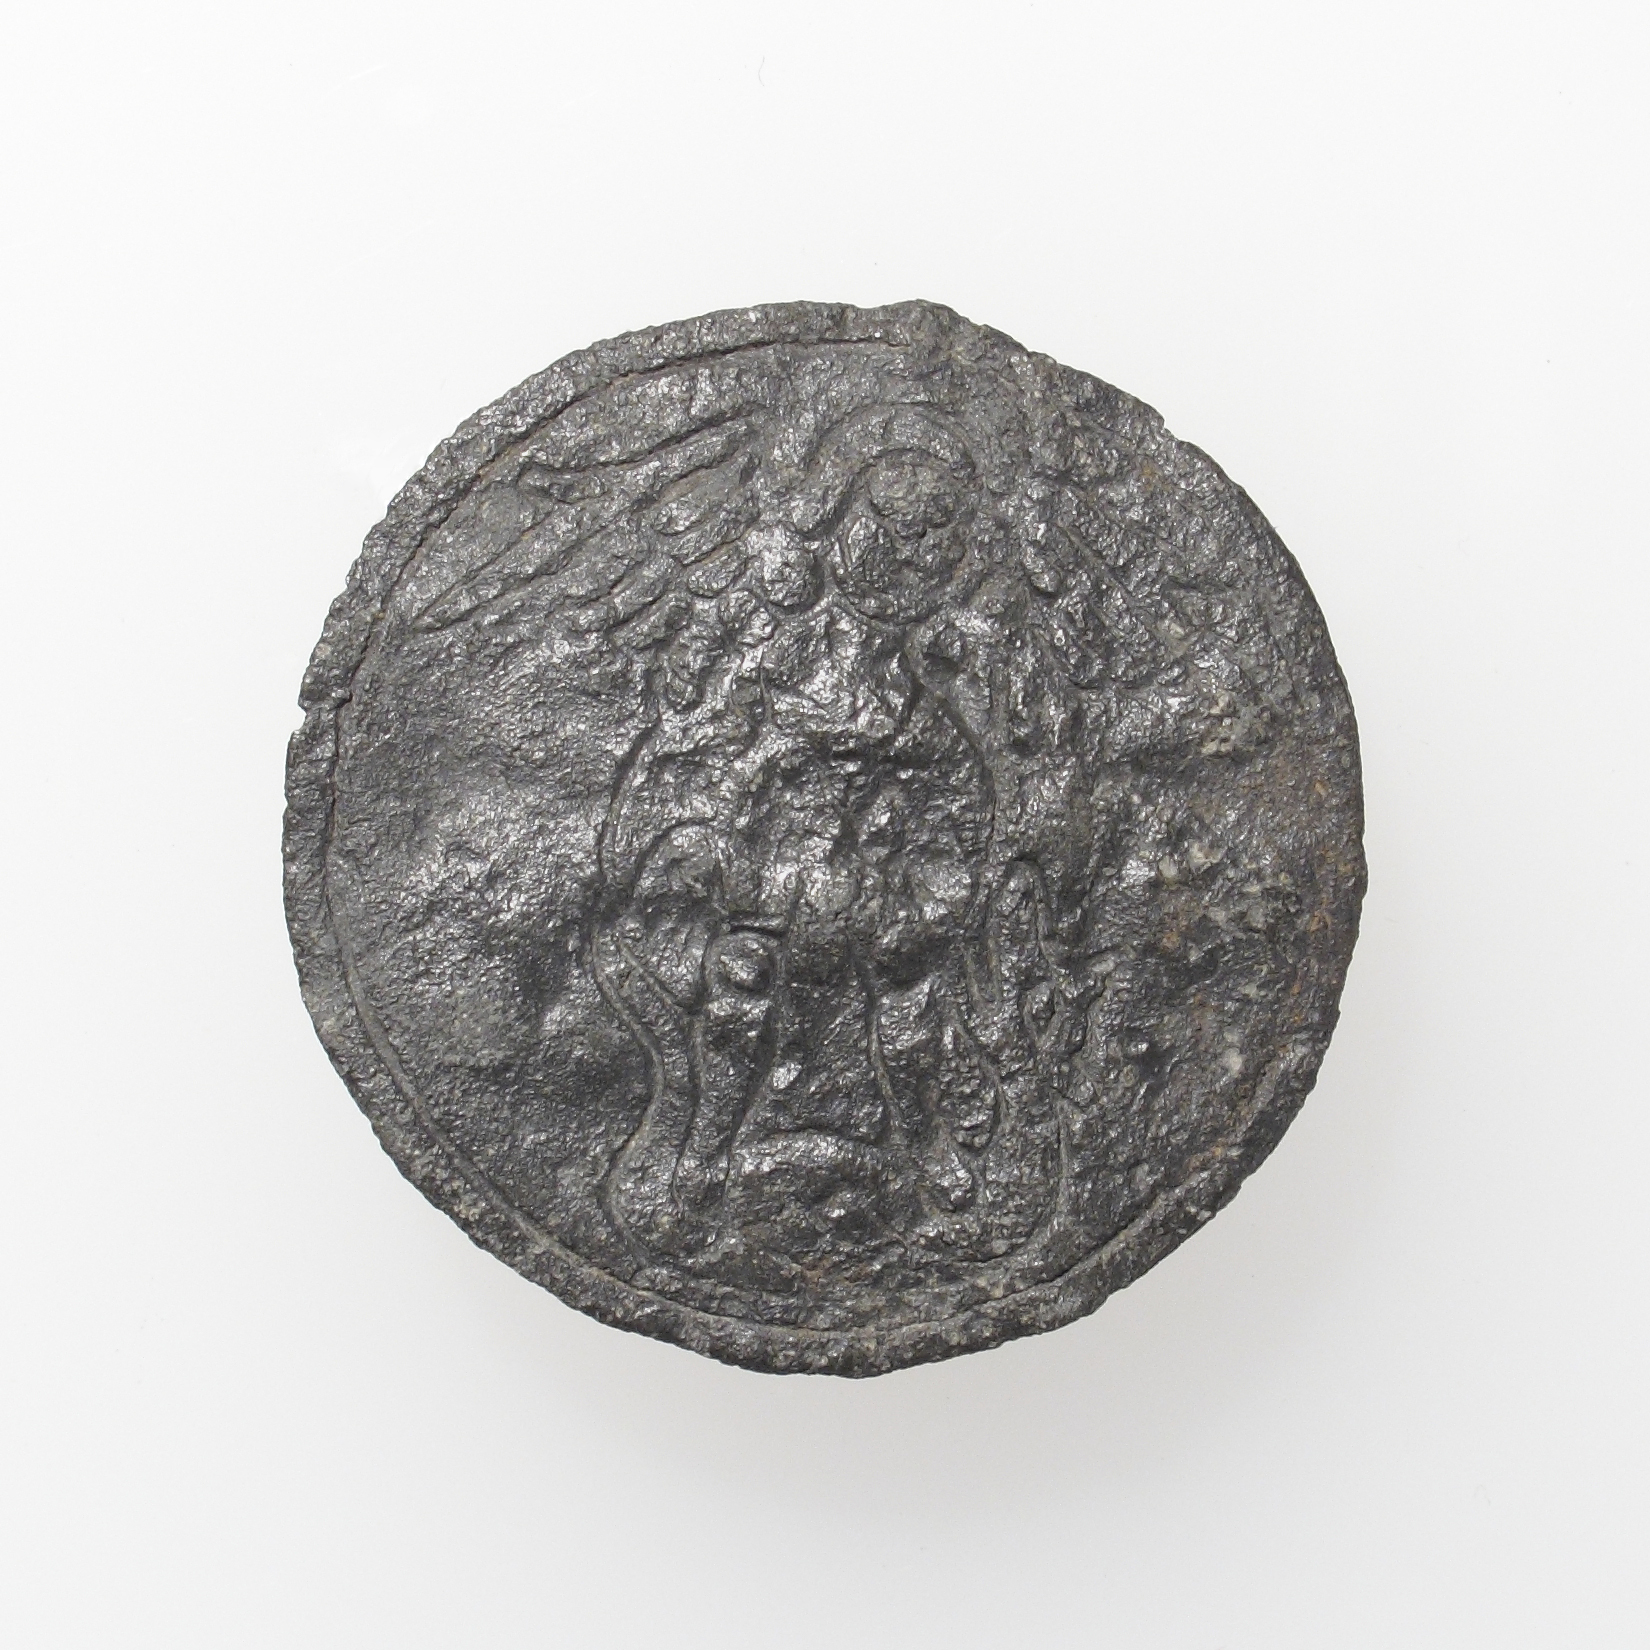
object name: pilgrim's badge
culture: french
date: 1301-1600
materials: lead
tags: angels